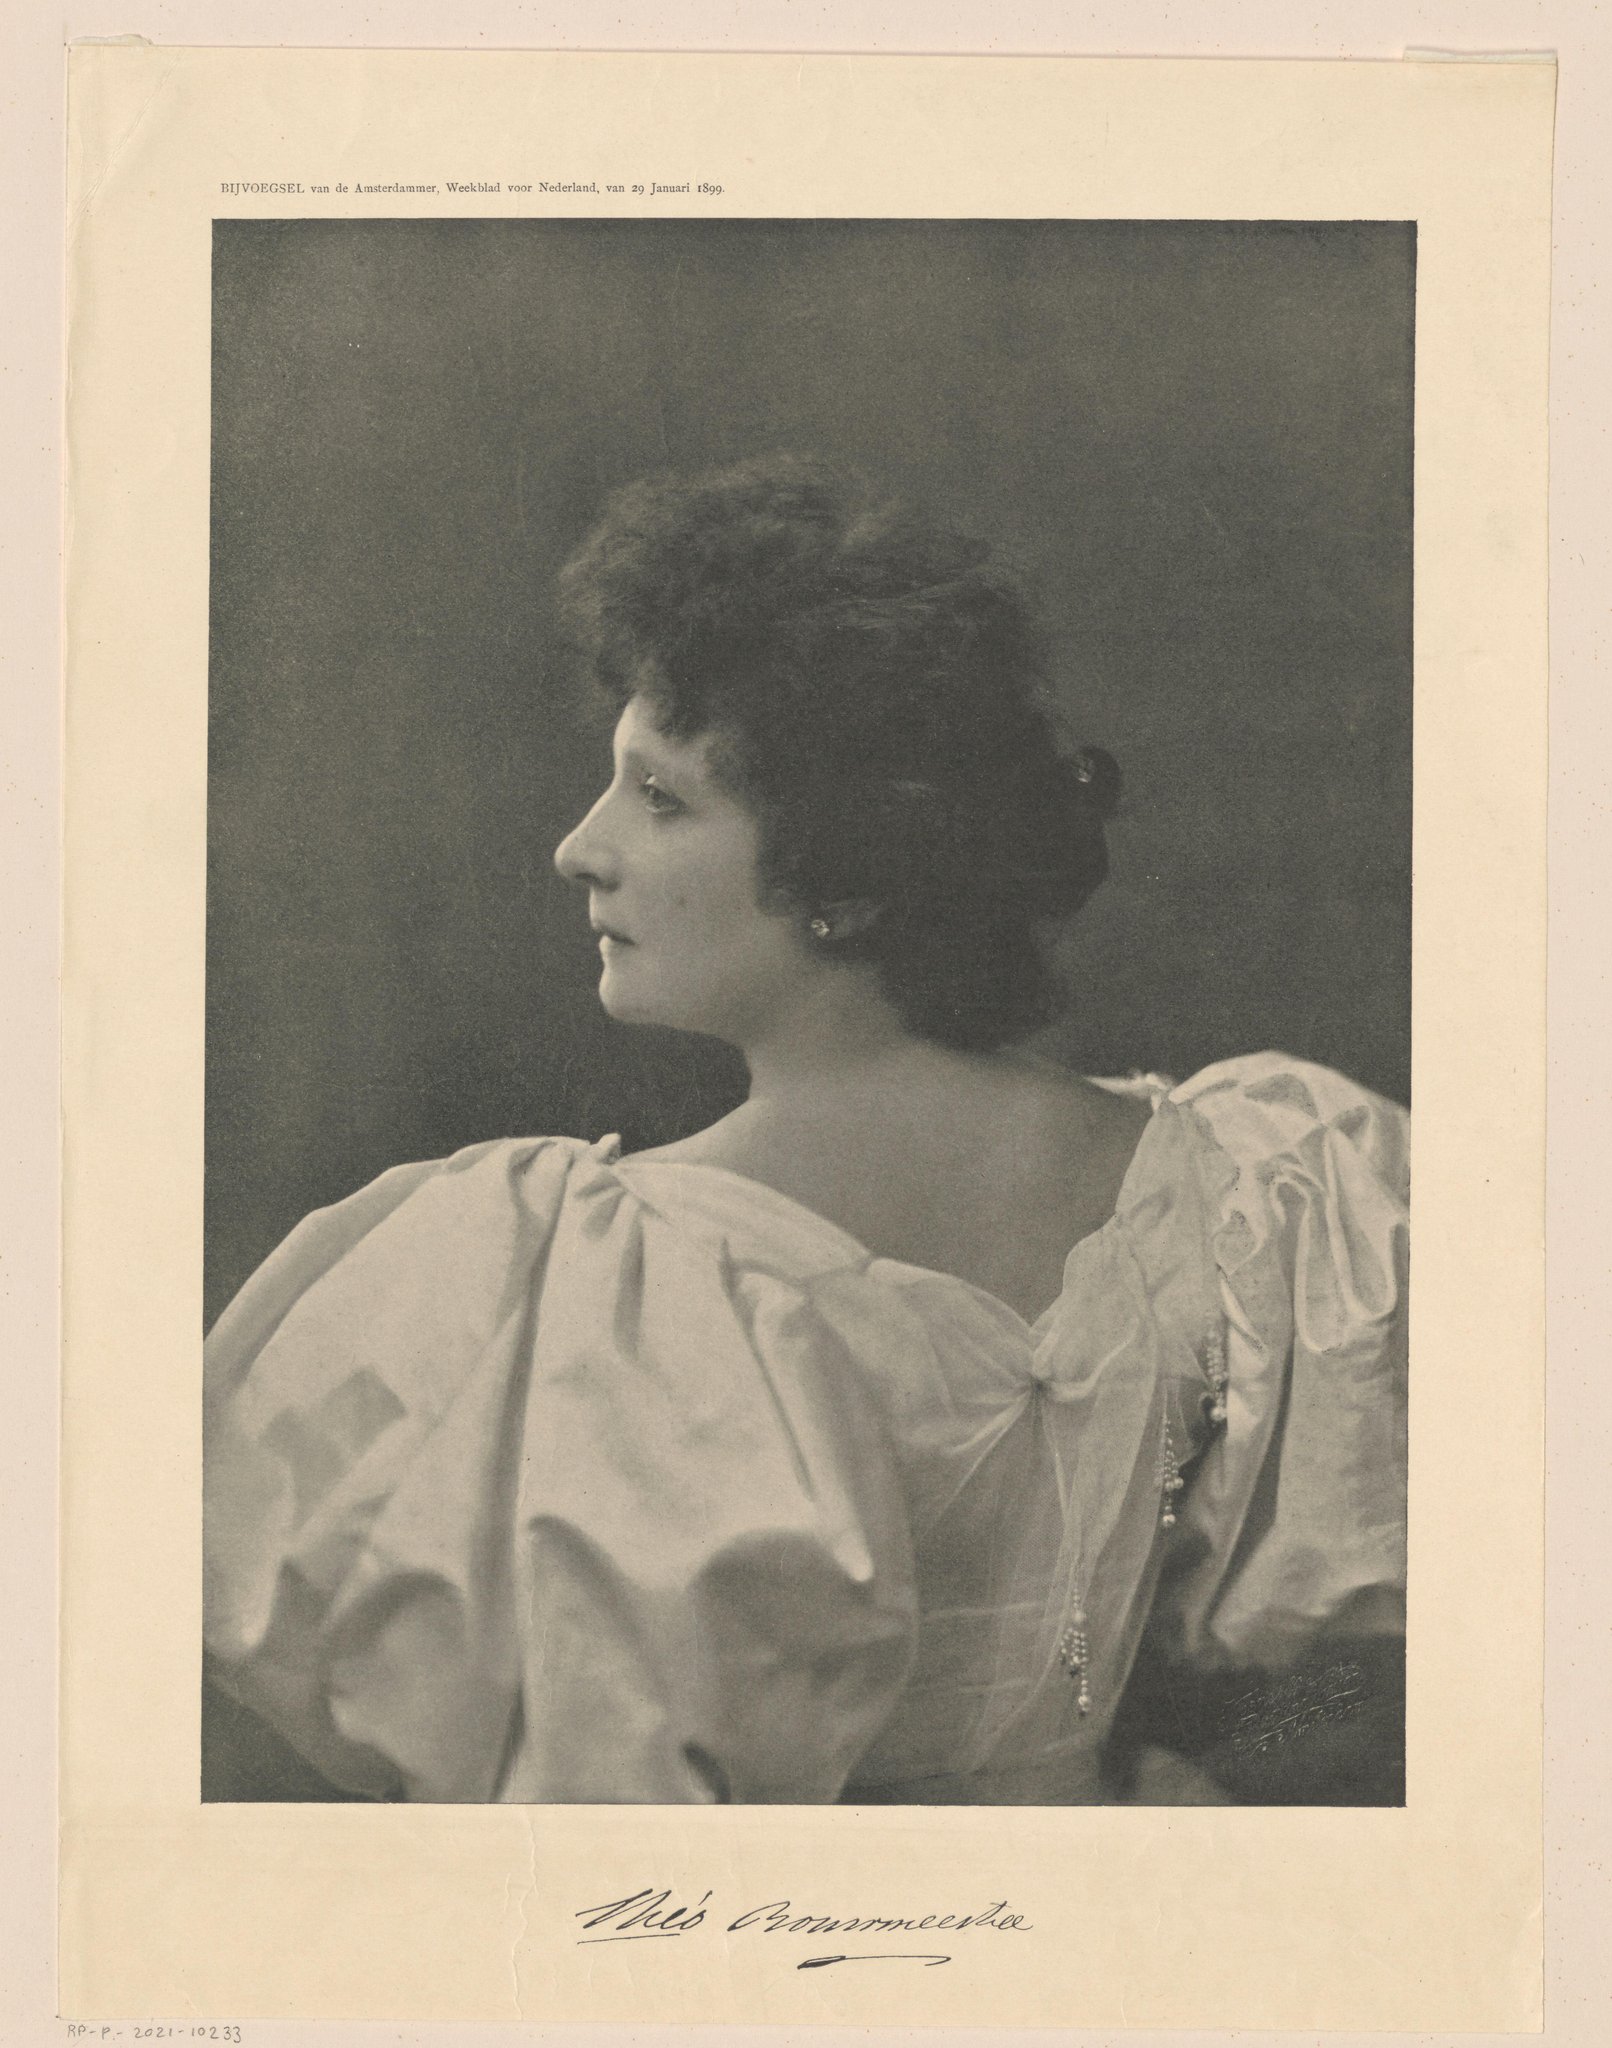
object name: photomechanical print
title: Portret van Theo Mann-Bouwmeester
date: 1899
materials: paper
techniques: autotype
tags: amsterdam, historical persons - bb - woman, portrait of actor, actress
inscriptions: date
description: Verschenen in het bijvoegsel van: De Amsterdammer, Weekblad voor Nederland, 29 januari 1899.